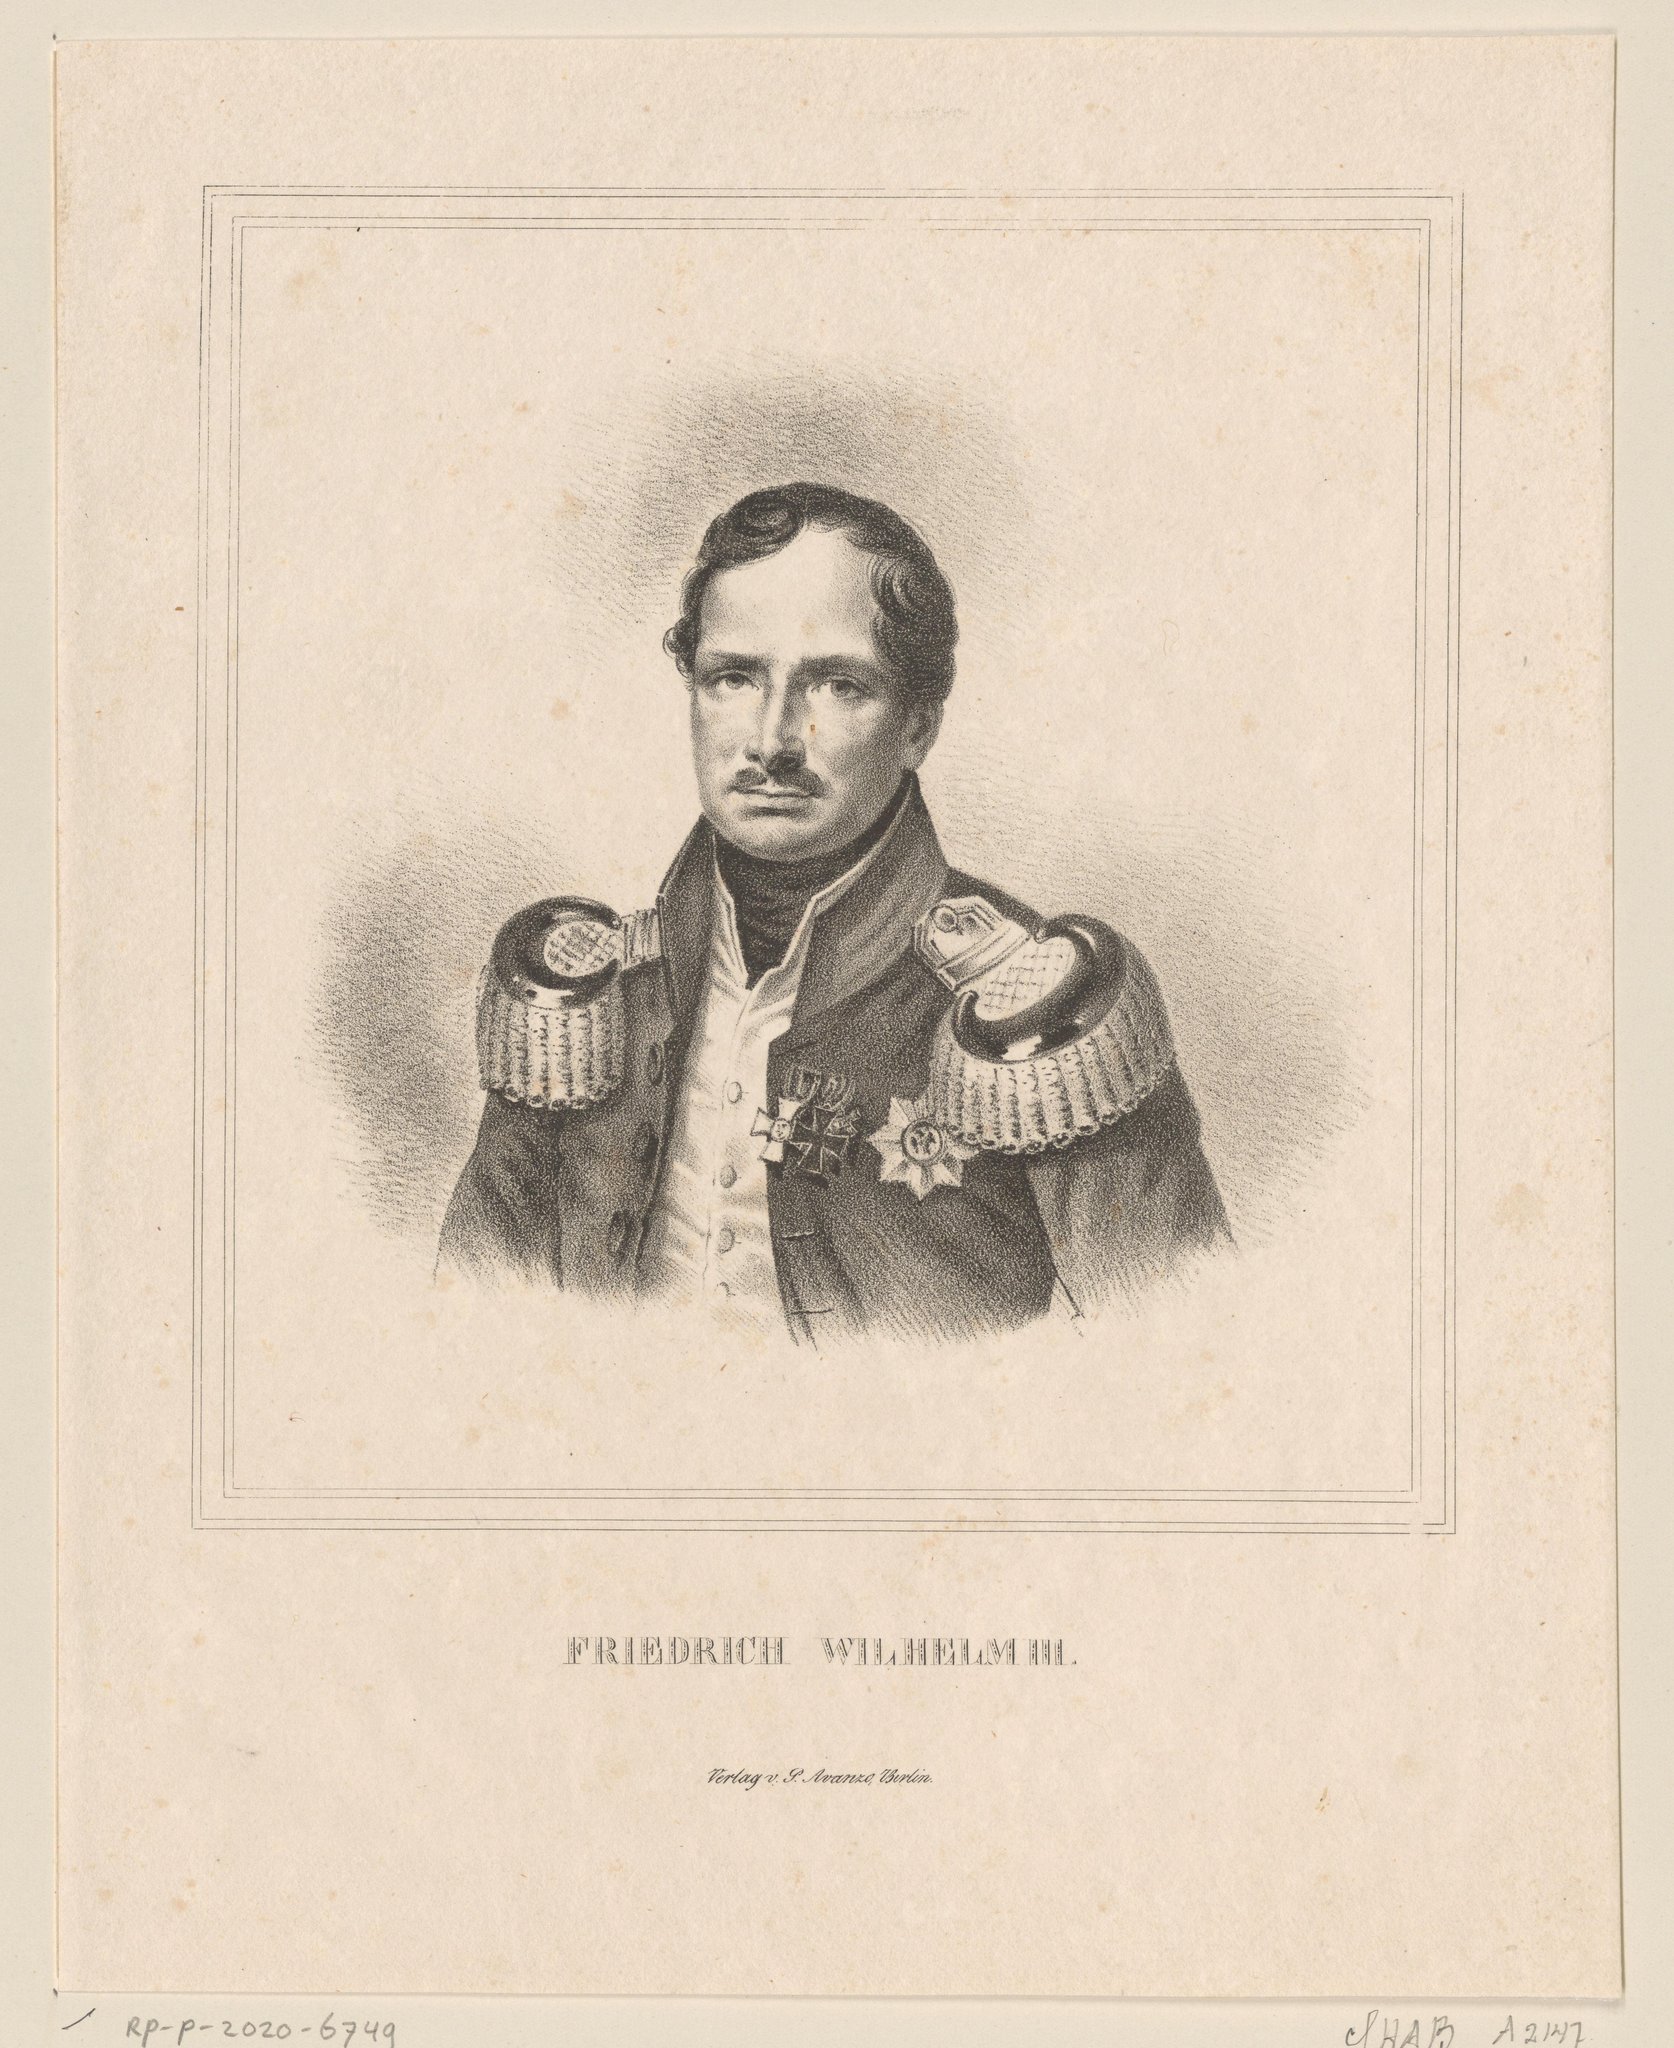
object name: print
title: Portret van Frederik Willem III van Pruisen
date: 1800-1850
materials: paper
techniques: lithograph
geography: germany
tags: berlin, frederik willem iii koning van pruisen, historical persons, (military) uniforms, king